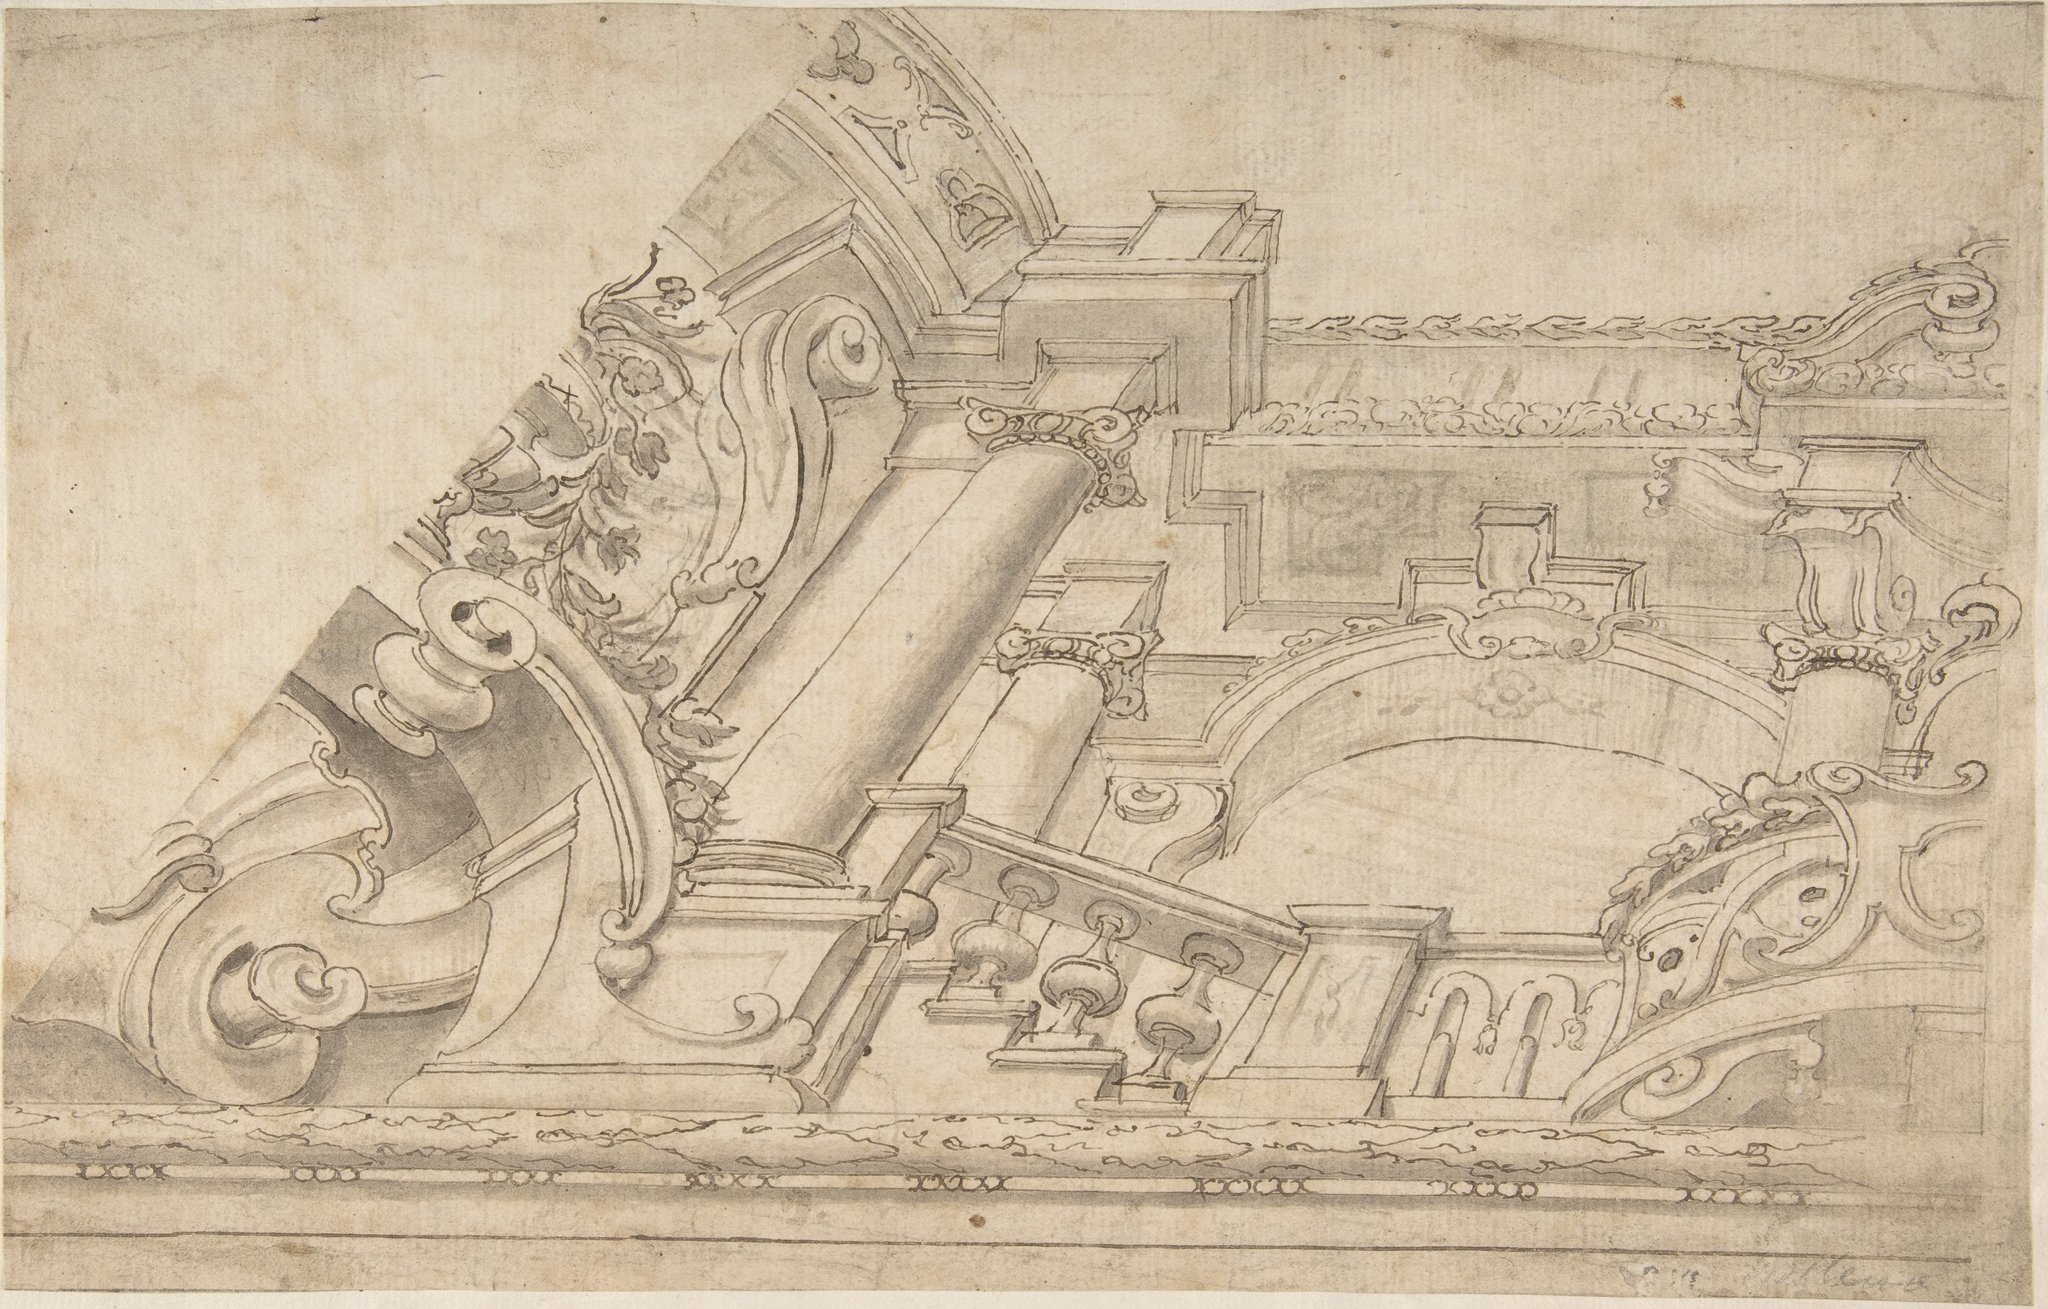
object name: drawing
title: Perspective Design for a Ceiling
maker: anonymous, italian, 18th century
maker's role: artist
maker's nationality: italian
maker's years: 1700-1800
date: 1701-1800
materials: ink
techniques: pen, wash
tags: architecture